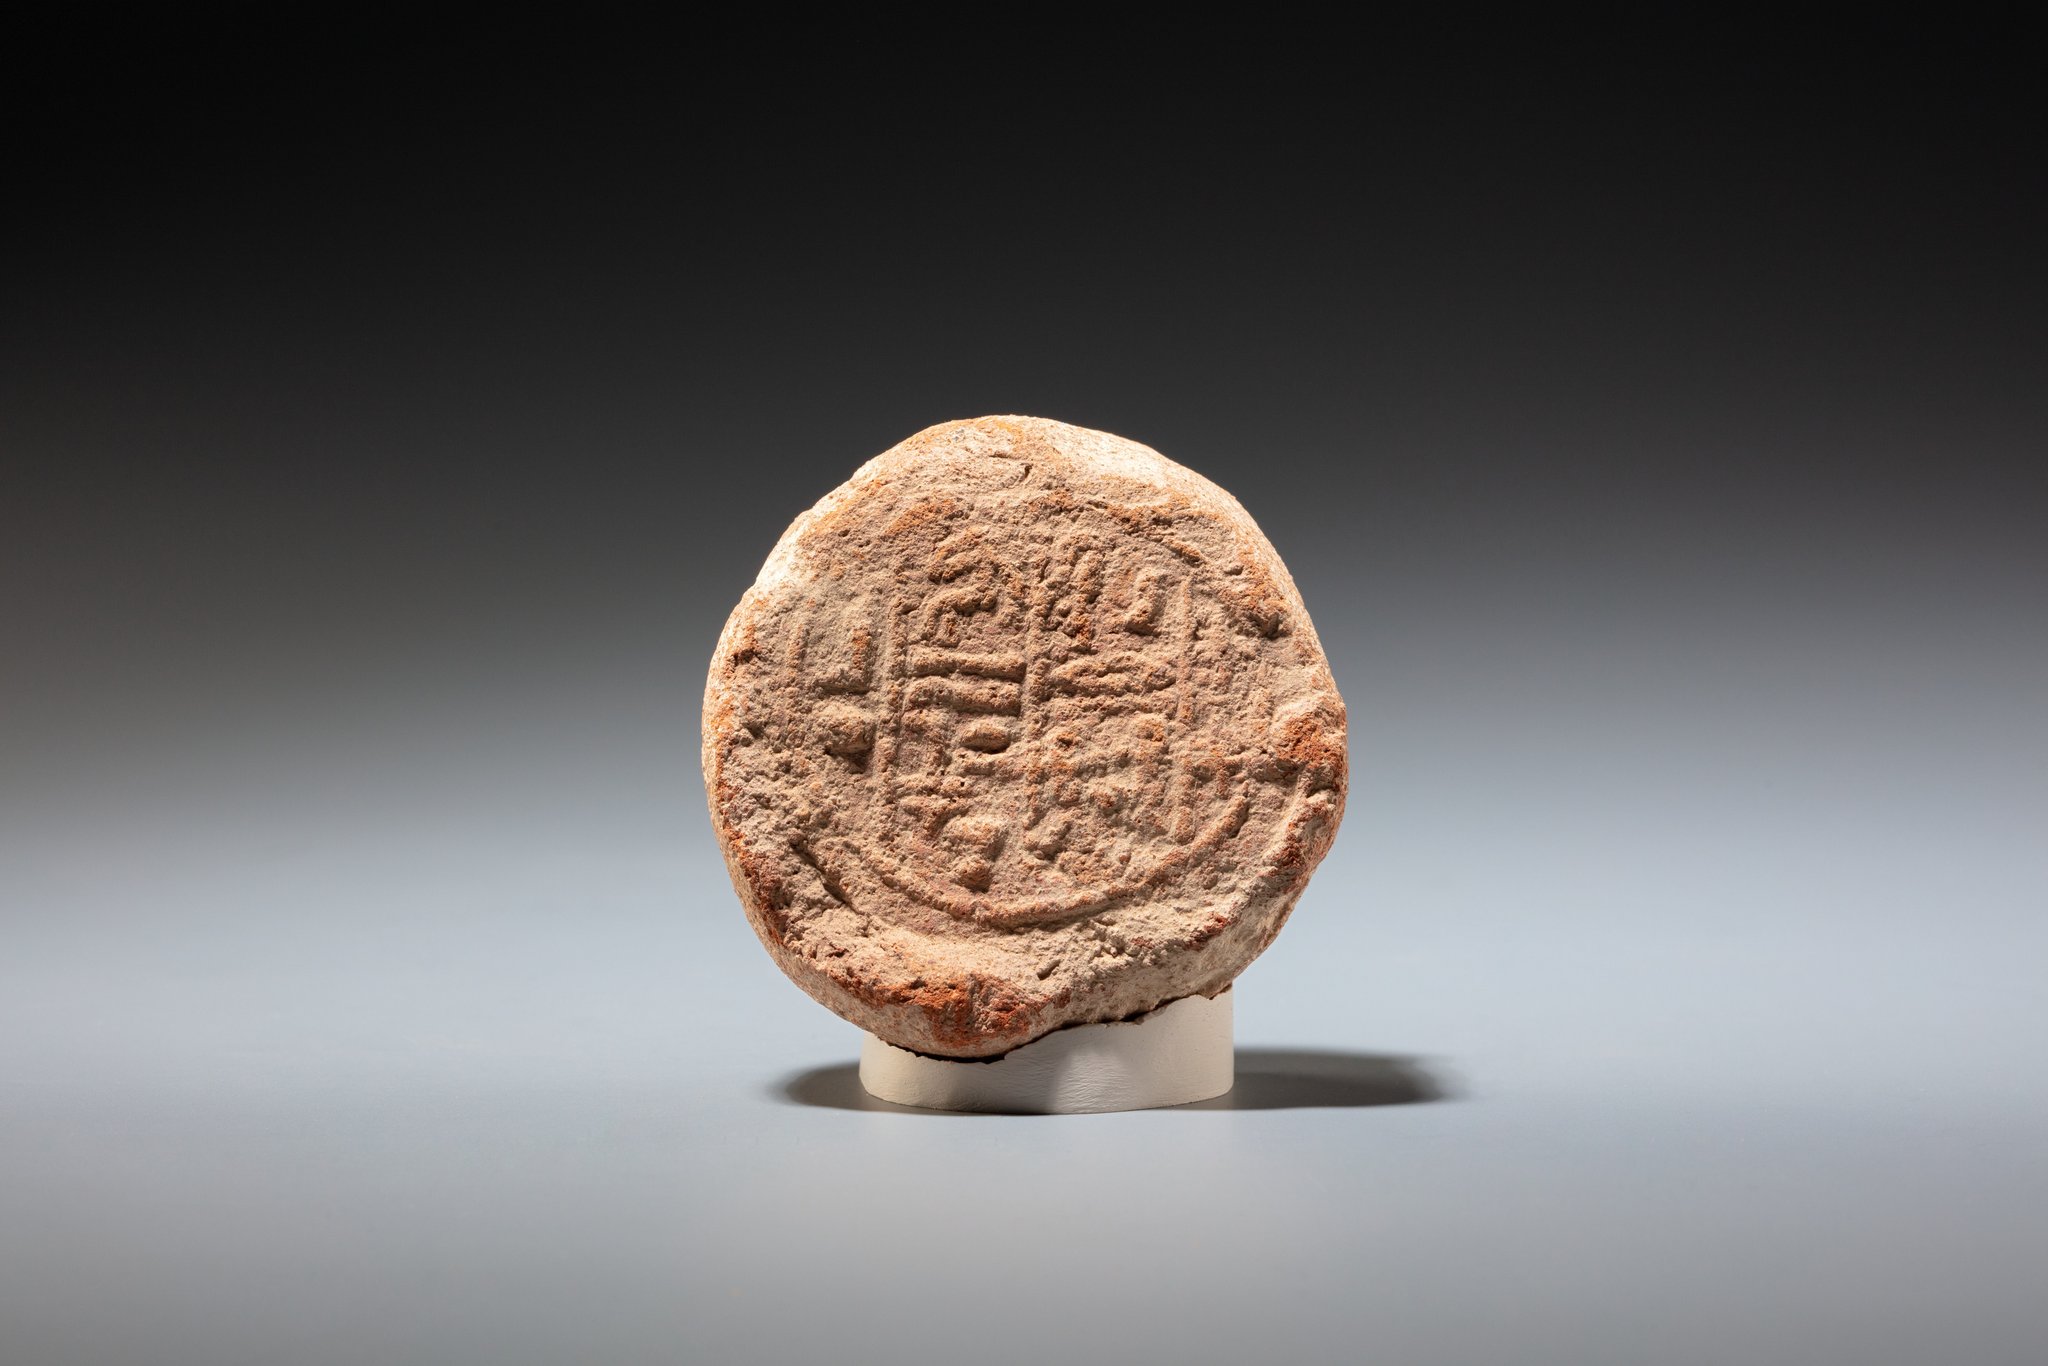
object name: cone, heqarneheh, circular impression, nursery, child, royal tutor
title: Funerary Cone of the Royal Tutor Heqarneheh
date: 1427-1352 BCE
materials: pottery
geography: egypt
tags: hieroglyphs